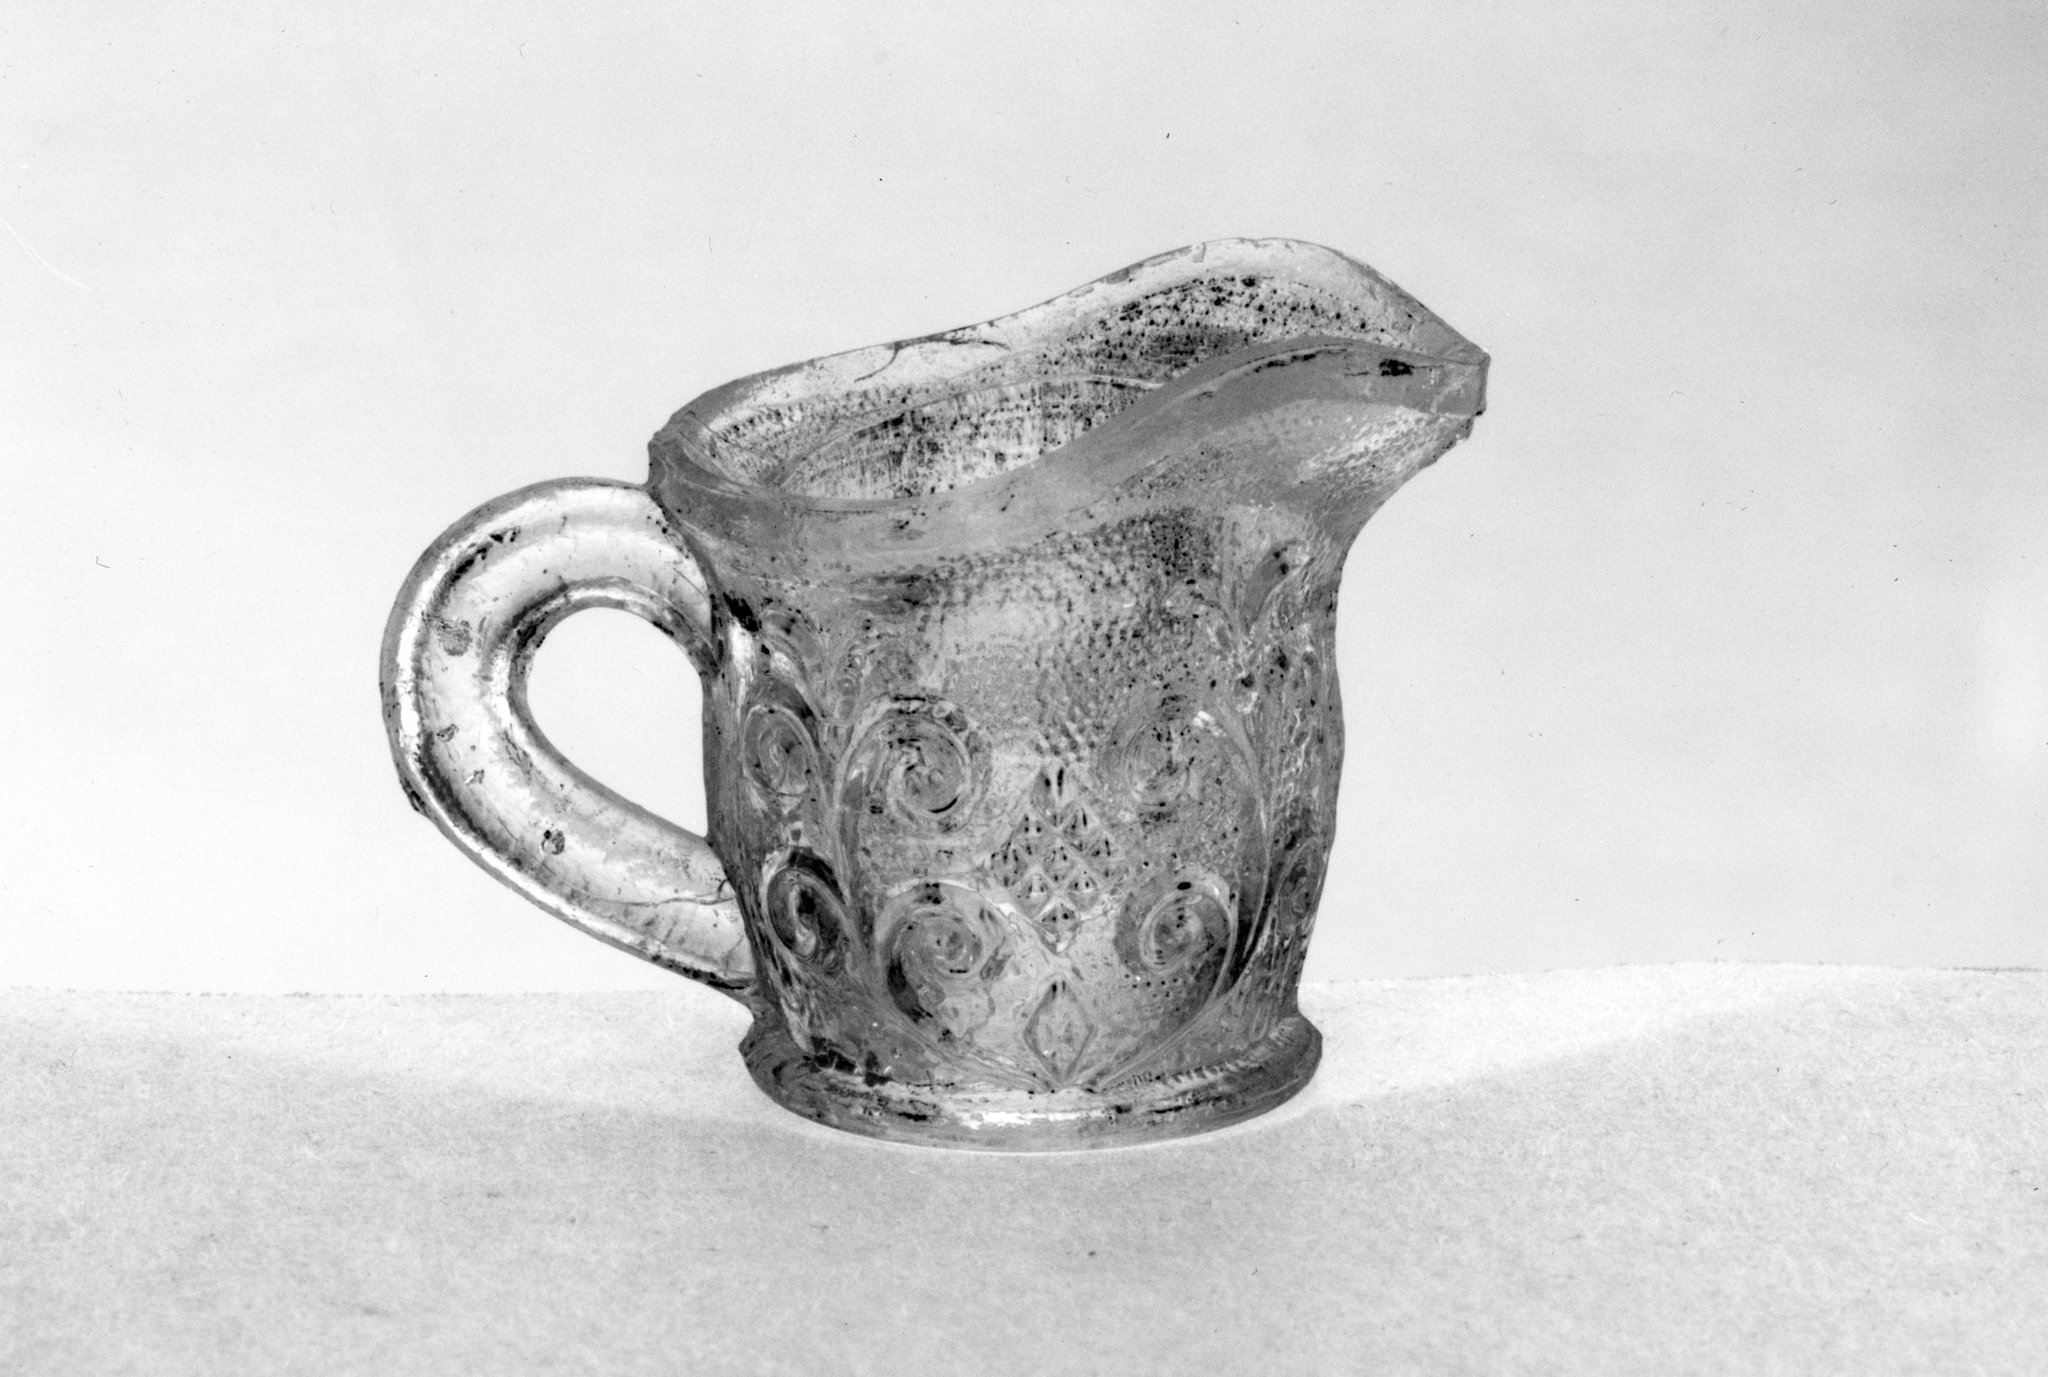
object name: pitcher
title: Miniature Pitcher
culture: american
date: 1835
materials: glass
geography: united states